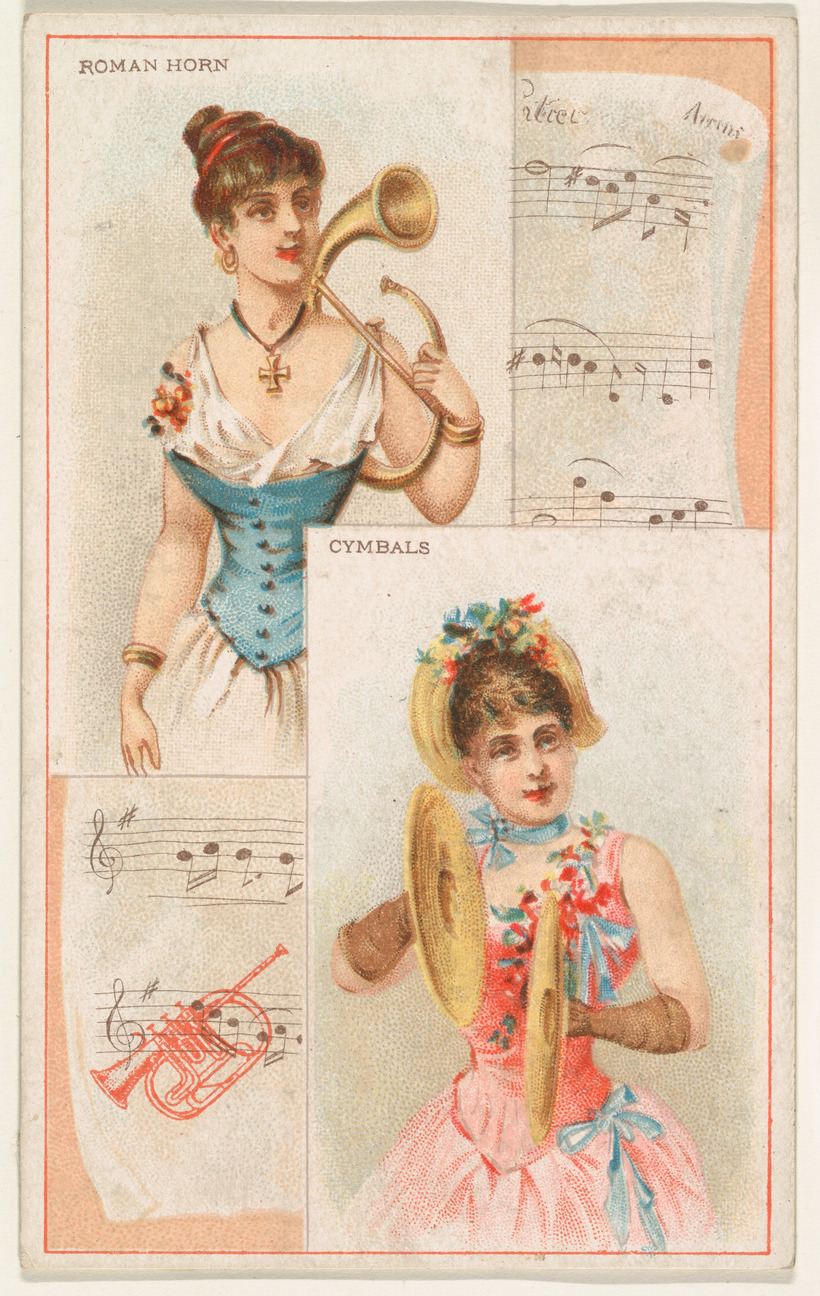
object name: print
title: Roman Horn and Cymbals, from the Musical Instruments series (N121) issued by Duke Sons & Co. to promote Honest Long Cut Tobacco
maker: w. duke, sons & co.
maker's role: publisher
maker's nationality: american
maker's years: 1870-1920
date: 1888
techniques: color lithograph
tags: musical instruments,women,horns